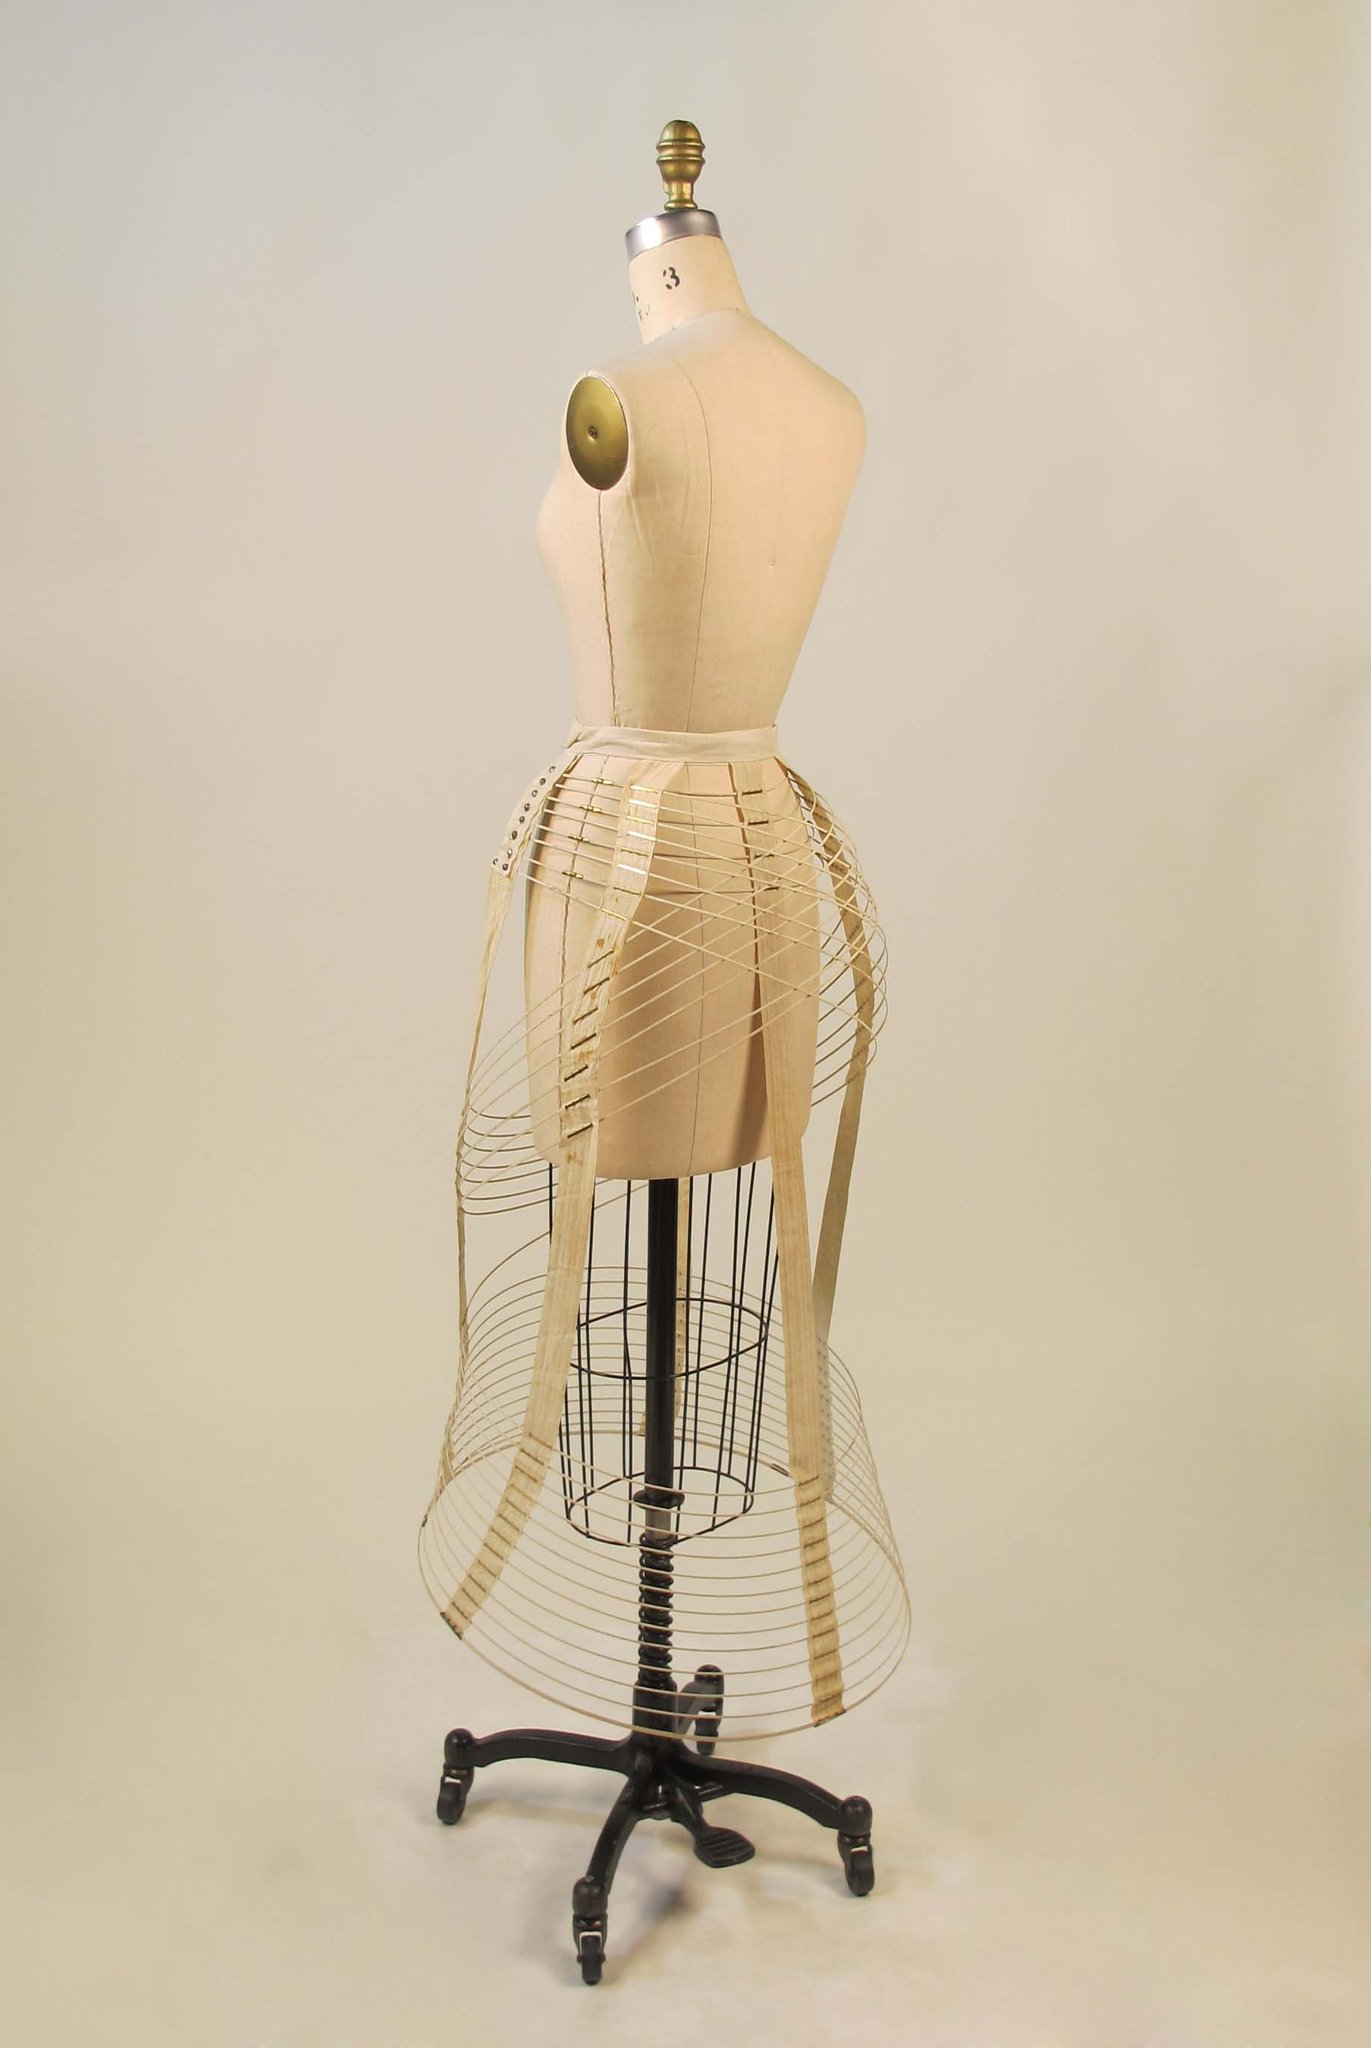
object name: bustle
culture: american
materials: cotton, metal